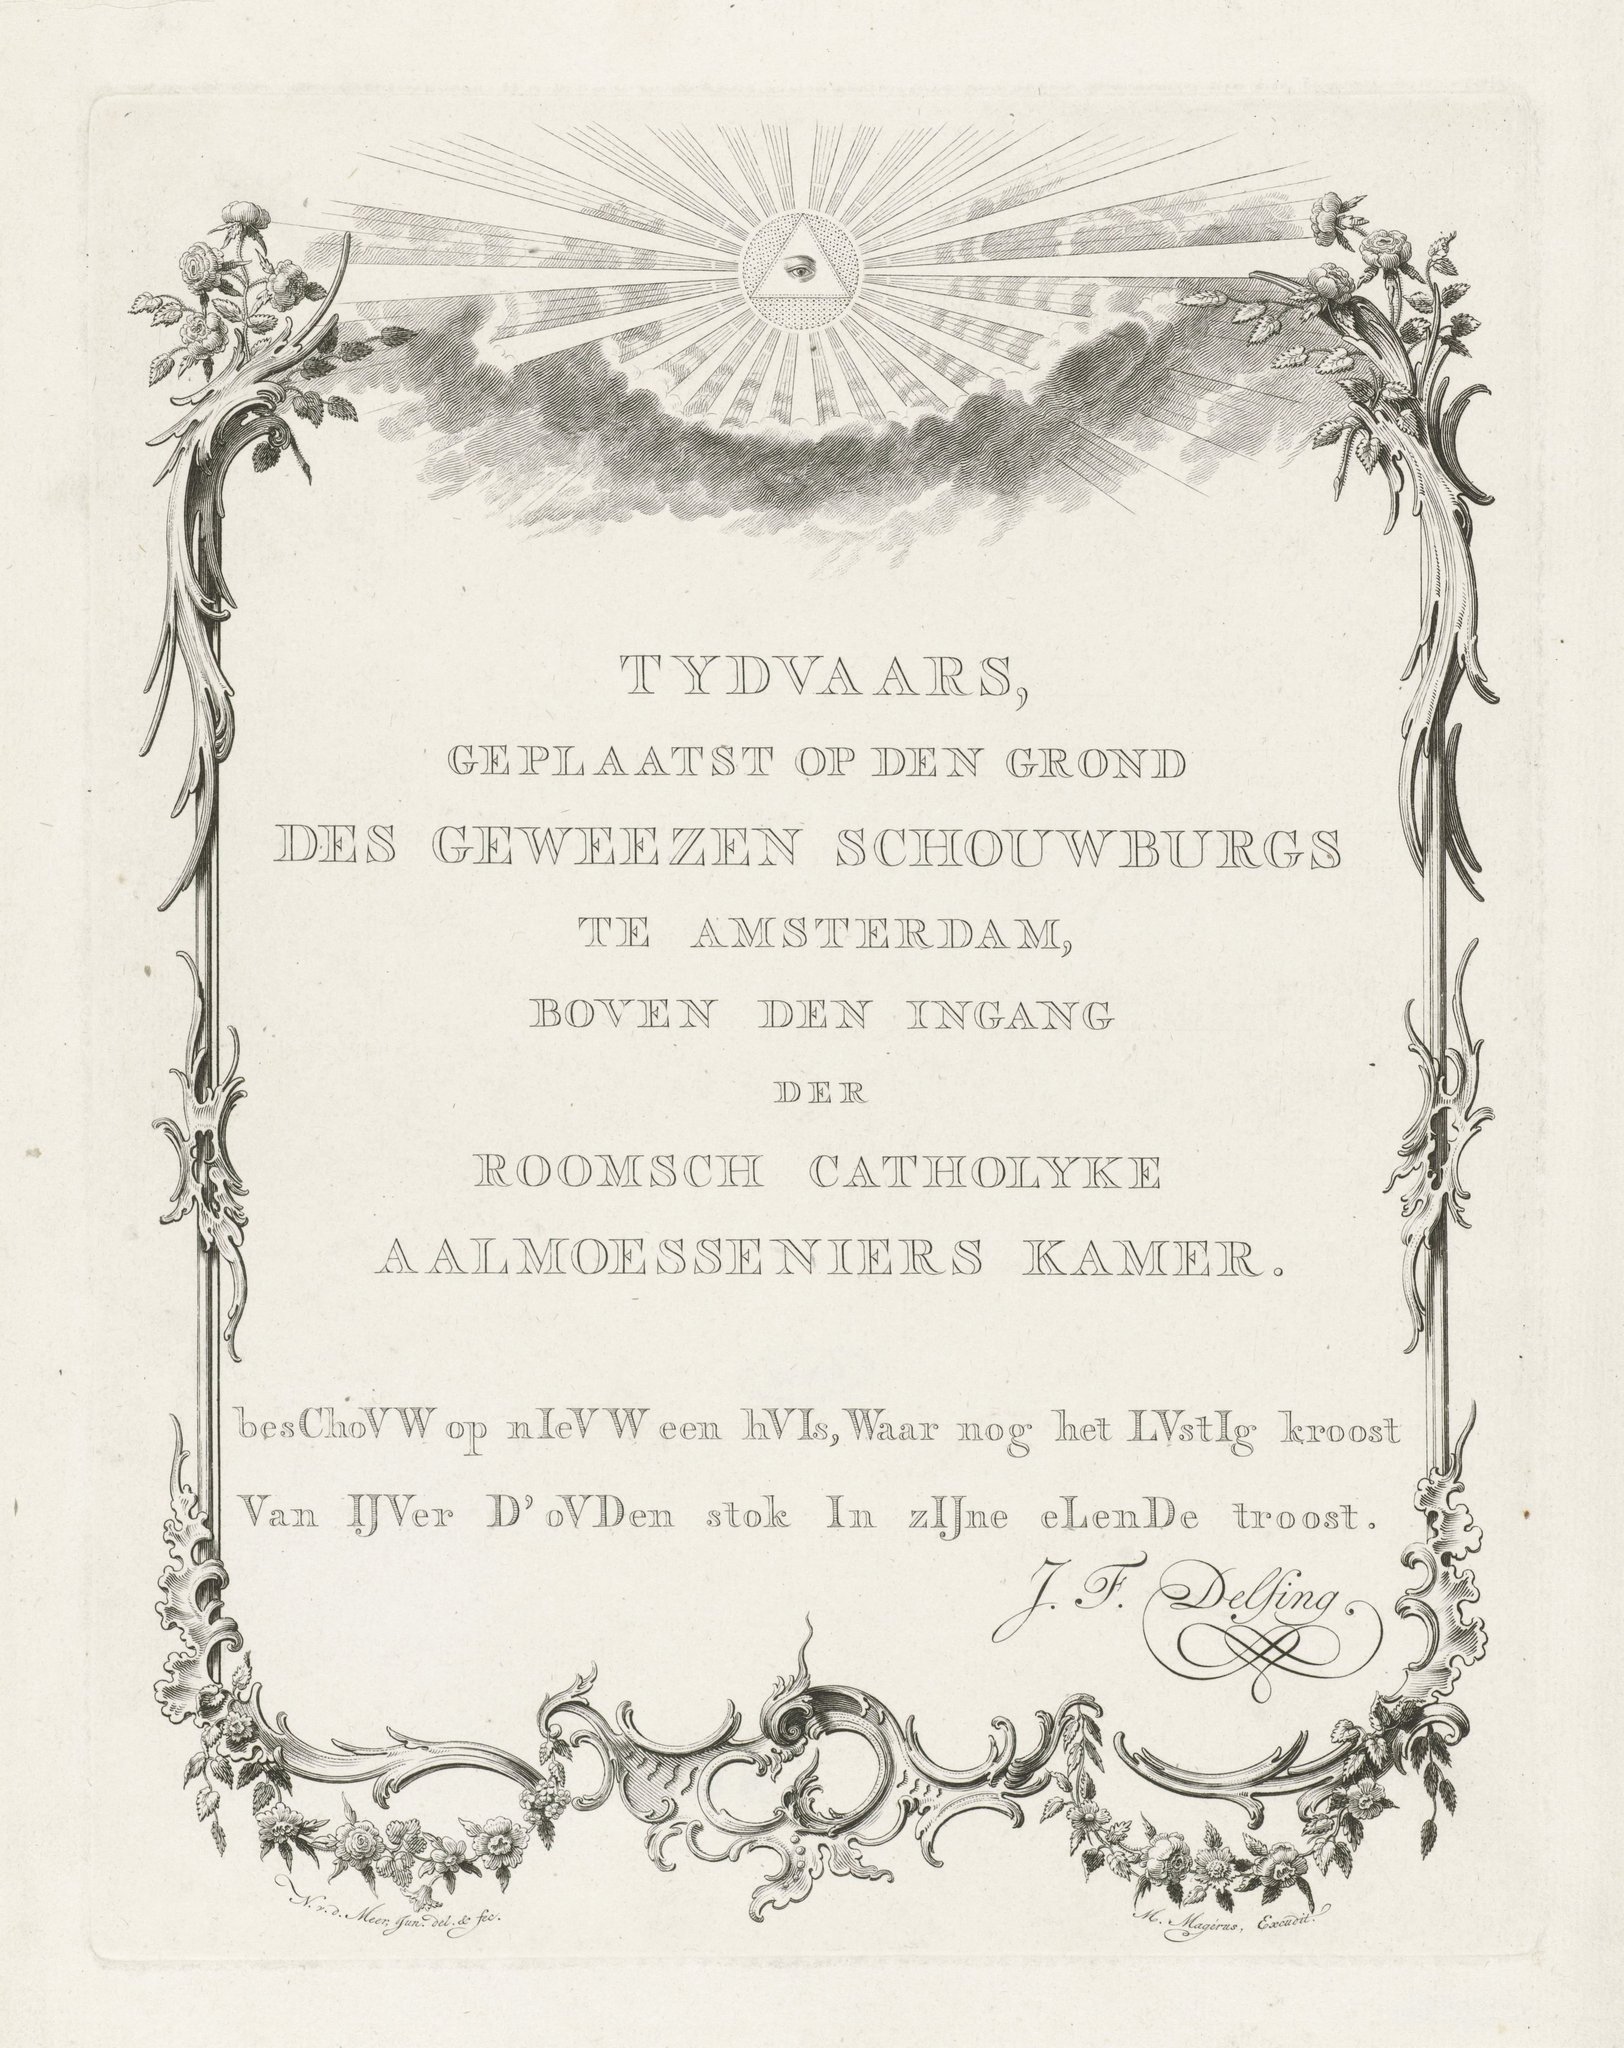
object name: print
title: Tijdvers op de bouw van het Rooms-Katholieke aalmoezenierskantoor op de plaats van de afgebrande schouwburg aan de Keizersgracht te Amsterdam, 1773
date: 1773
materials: paper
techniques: engraving, etching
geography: northern netherlands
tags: the all-seeing eye, triangle with eye ~ symbol of god the father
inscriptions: collector's mark: Lugt 2228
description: Binnen een omlijsting van rocailles, bloemen en het Alziende Oog een tijdvers in twee regels op de bouw in het jaar 1773 van het Rooms-Katholieke aalmoezenierskantoor op de plaats van de verbrande Schouwburg op de Keizersgracht.